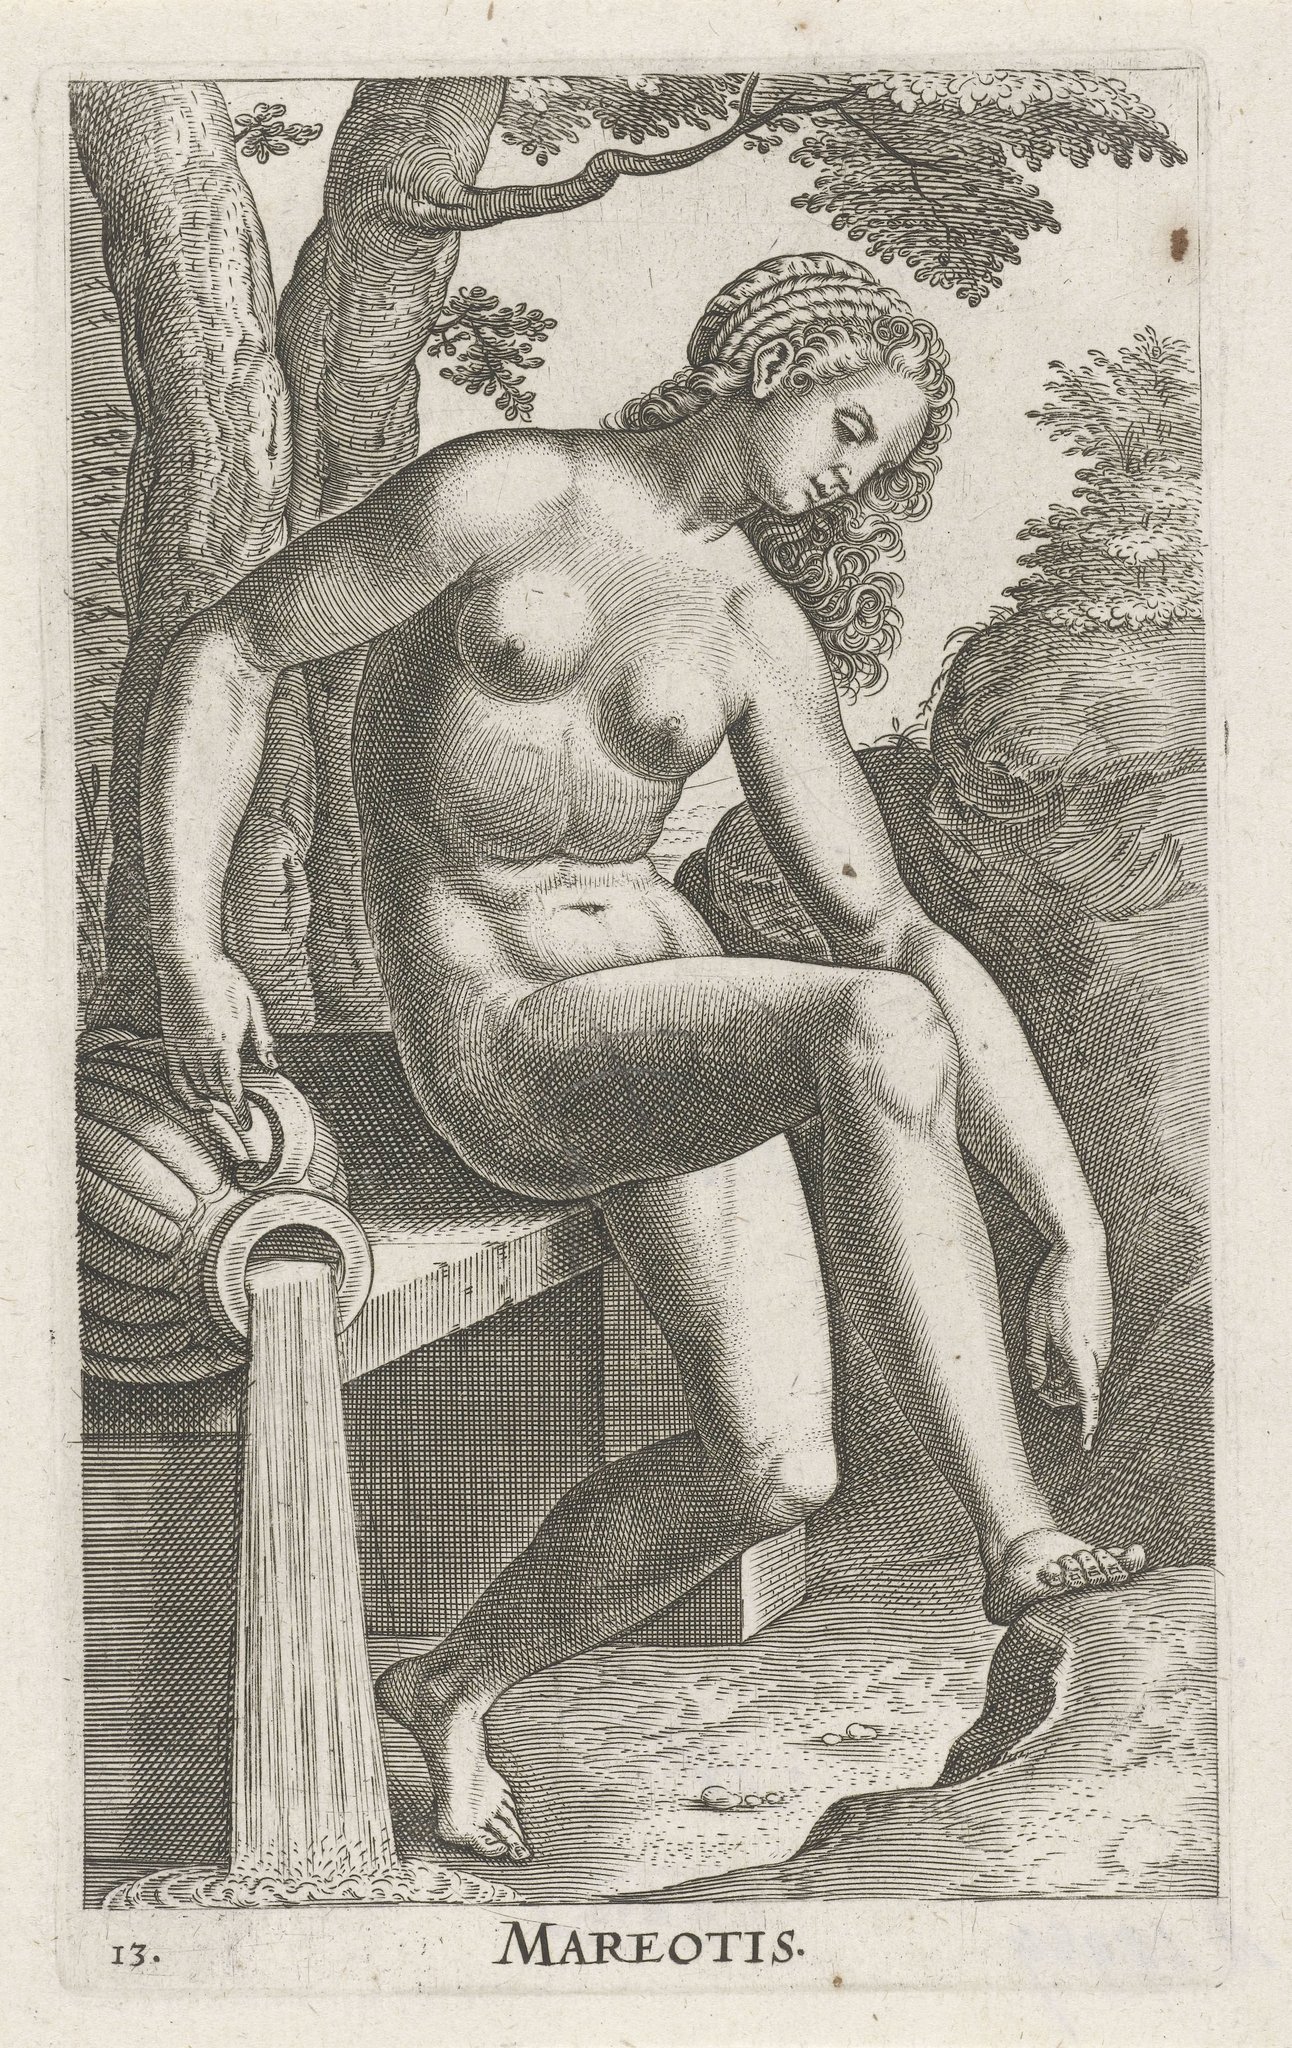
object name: print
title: Stroom- en waternimfen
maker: philips galle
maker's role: print maker, publisher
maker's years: 1537-1612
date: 1587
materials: paper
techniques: engraving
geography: antwerp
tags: river personified (with name)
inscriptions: collector's mark: Lugt 2228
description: De waternimf Mareotis (het meer Mariout), gezeten op een stenen bank. De prent maakt deel uit van een zeventiendelige serie over stroom- en waternimfen.